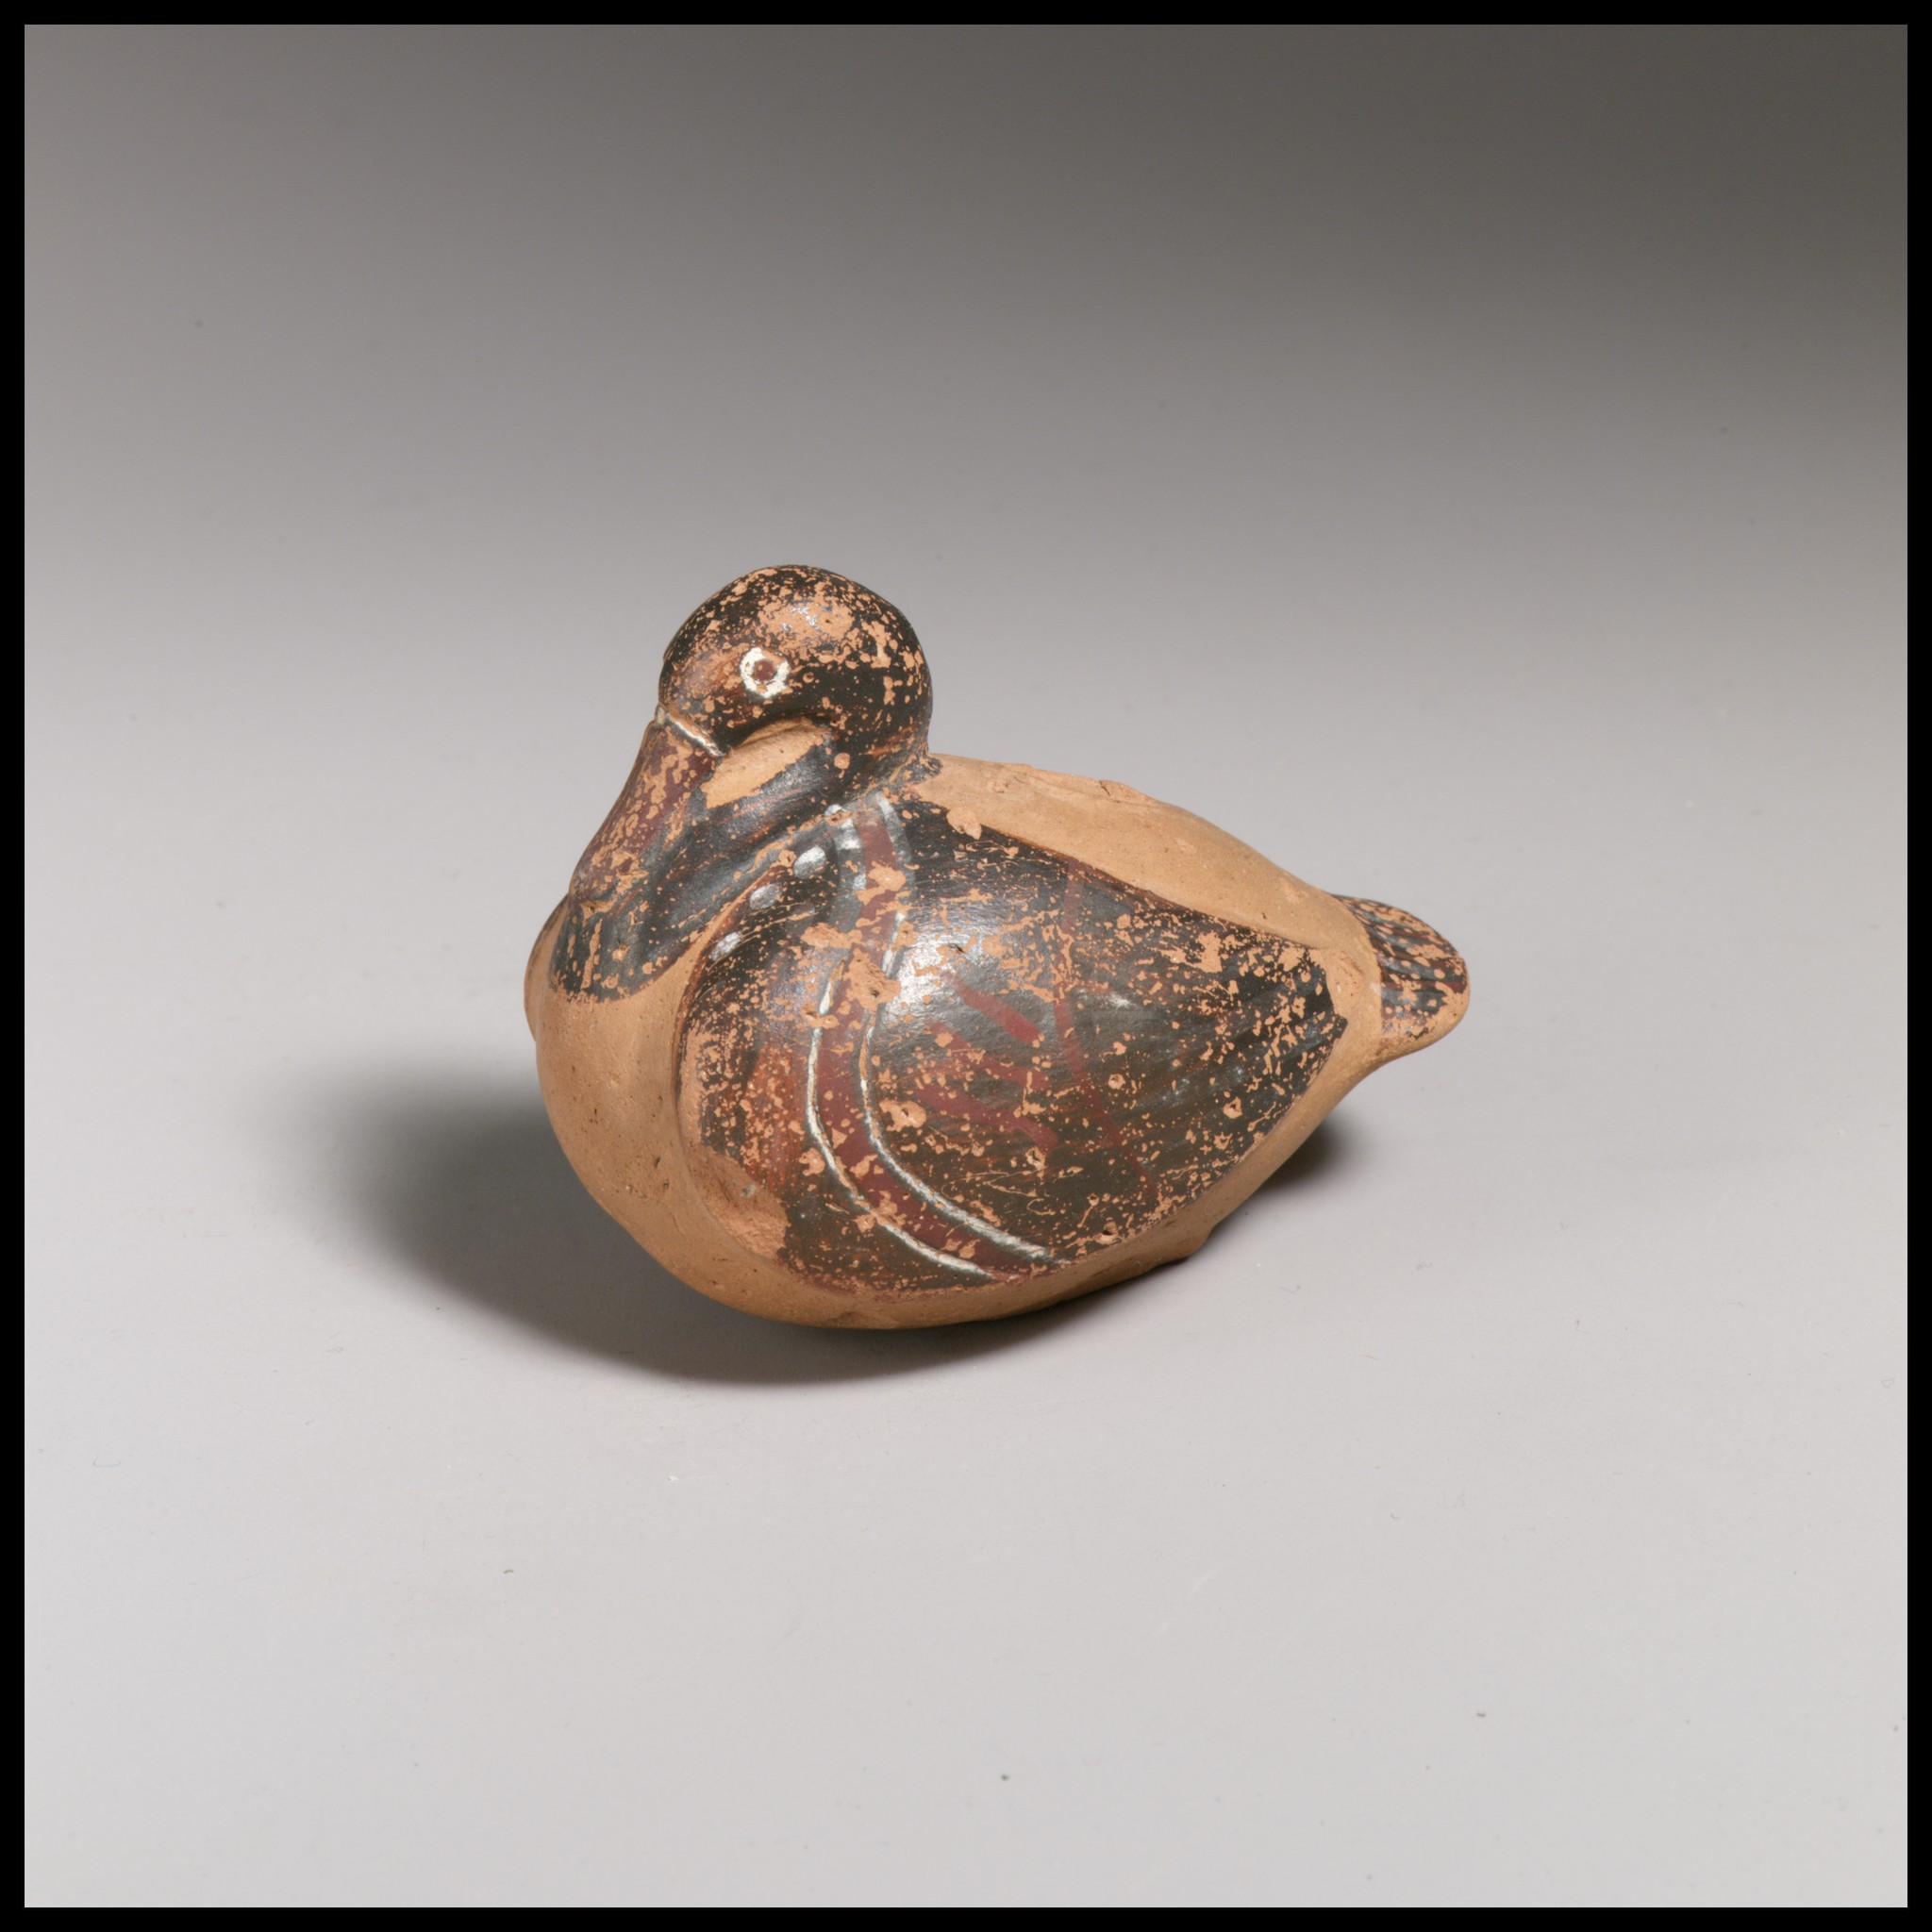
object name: vase in the form of a duck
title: Terracotta vase in the form of a duck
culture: greek, corinthian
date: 600-501 BCE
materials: terracotta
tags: ducks